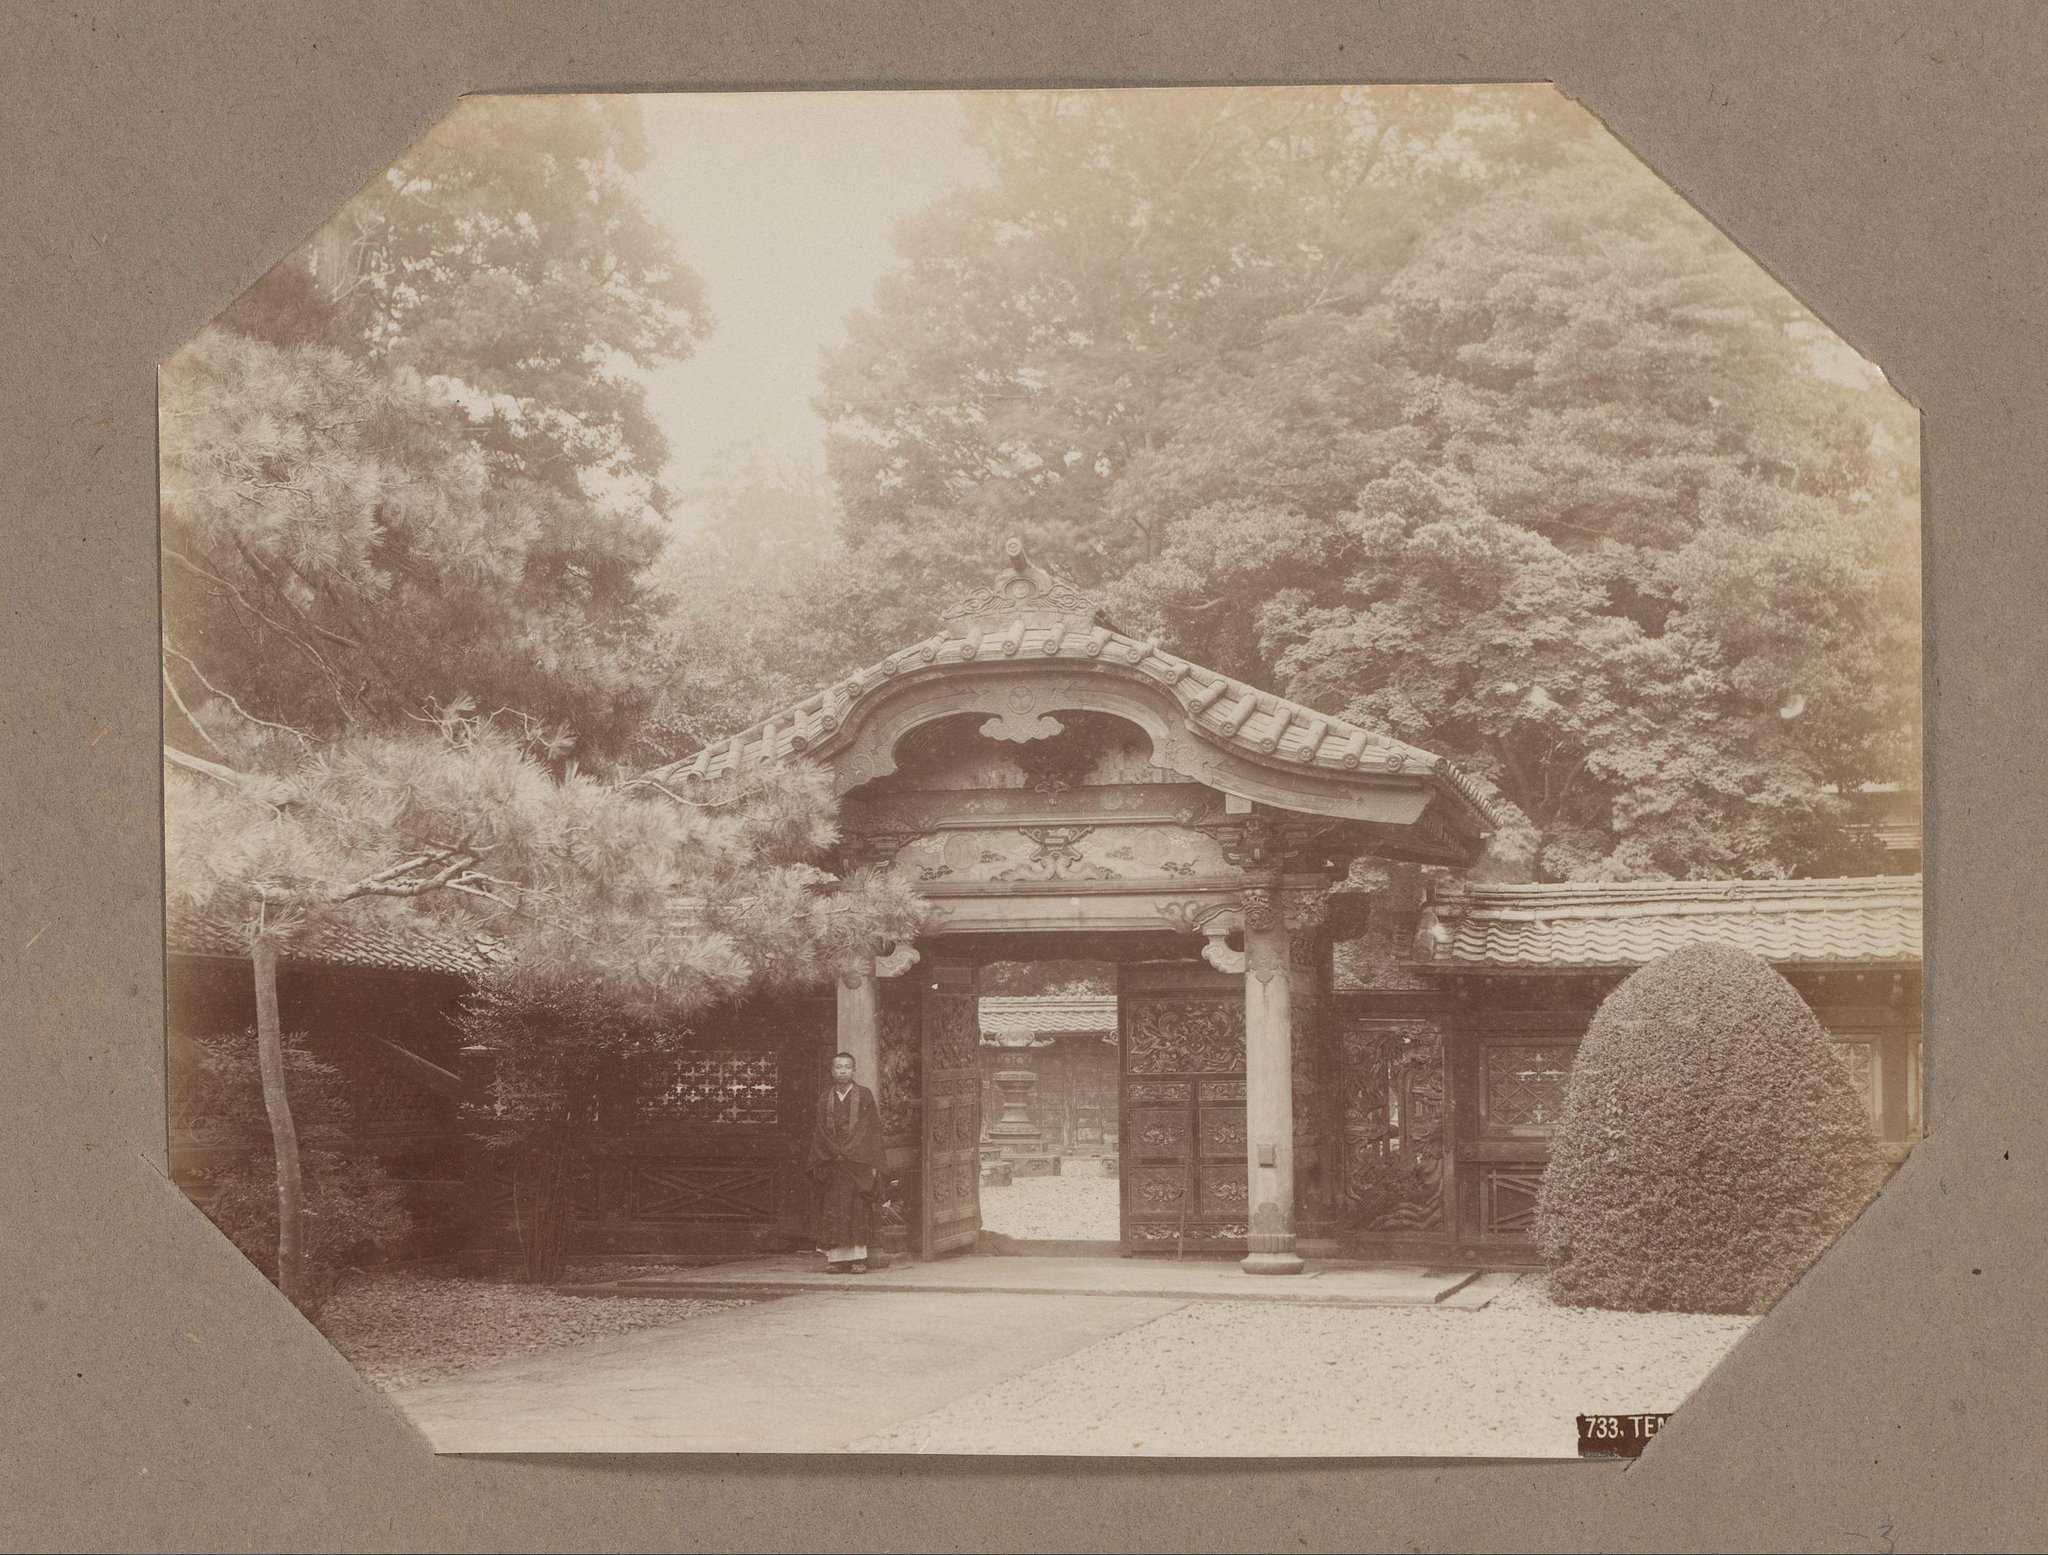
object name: photograph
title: Man bij de poort van een tempel in Shiba, Tokyo, Japan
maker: kusakabe kimbei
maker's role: fotograaf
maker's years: 1841-1934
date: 1890-1903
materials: paper, photographic support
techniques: albumen print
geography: tokyo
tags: temple, shrine ~ shinto, adult man, gate, entrance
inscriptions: inscription: ‘733. Temple. Shiba Tokyo.’